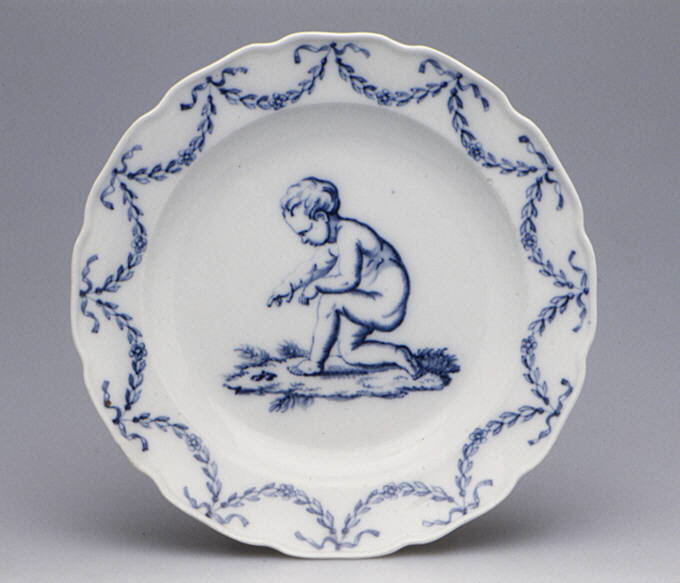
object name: plate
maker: meissen manufactory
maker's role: manufactory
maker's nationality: german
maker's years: 1710-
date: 1765-1770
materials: hard paste porcelain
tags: children